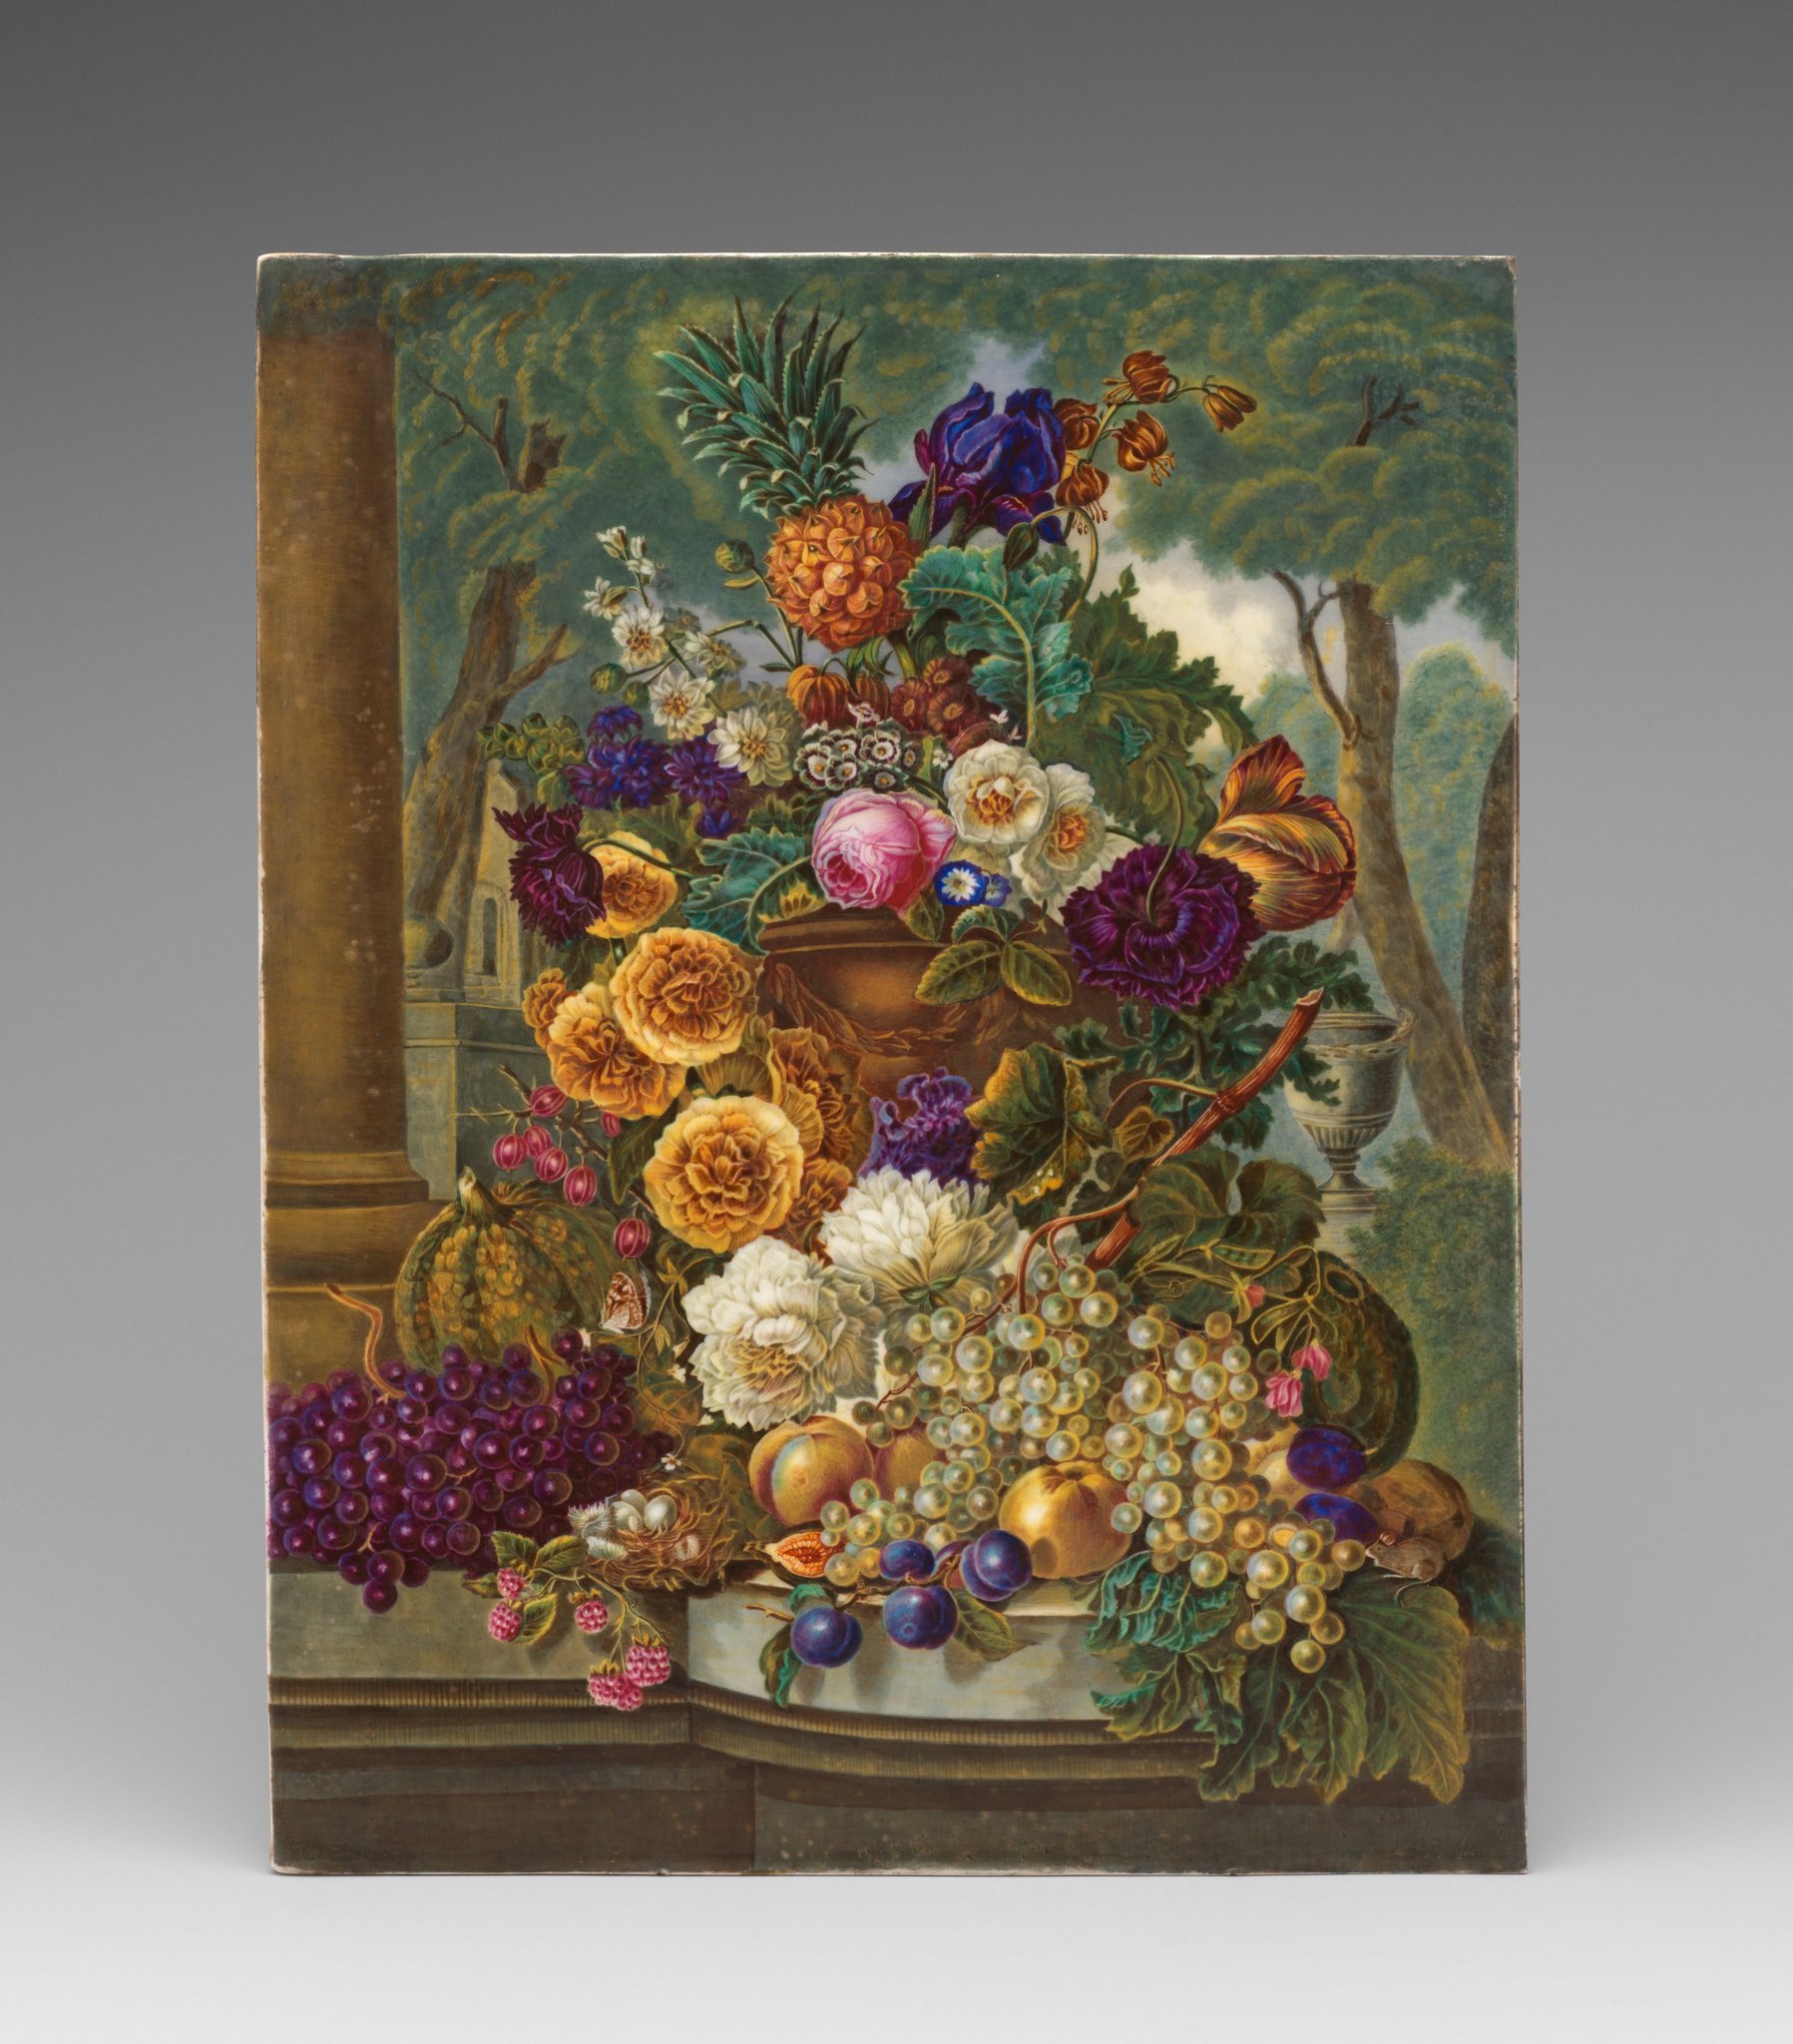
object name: plaque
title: An urn overflowing with fruit and flowers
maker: derby porcelain manufactory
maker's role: factory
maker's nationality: british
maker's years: 1751-1785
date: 1825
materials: bone china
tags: apples,grapes,flowers,urns